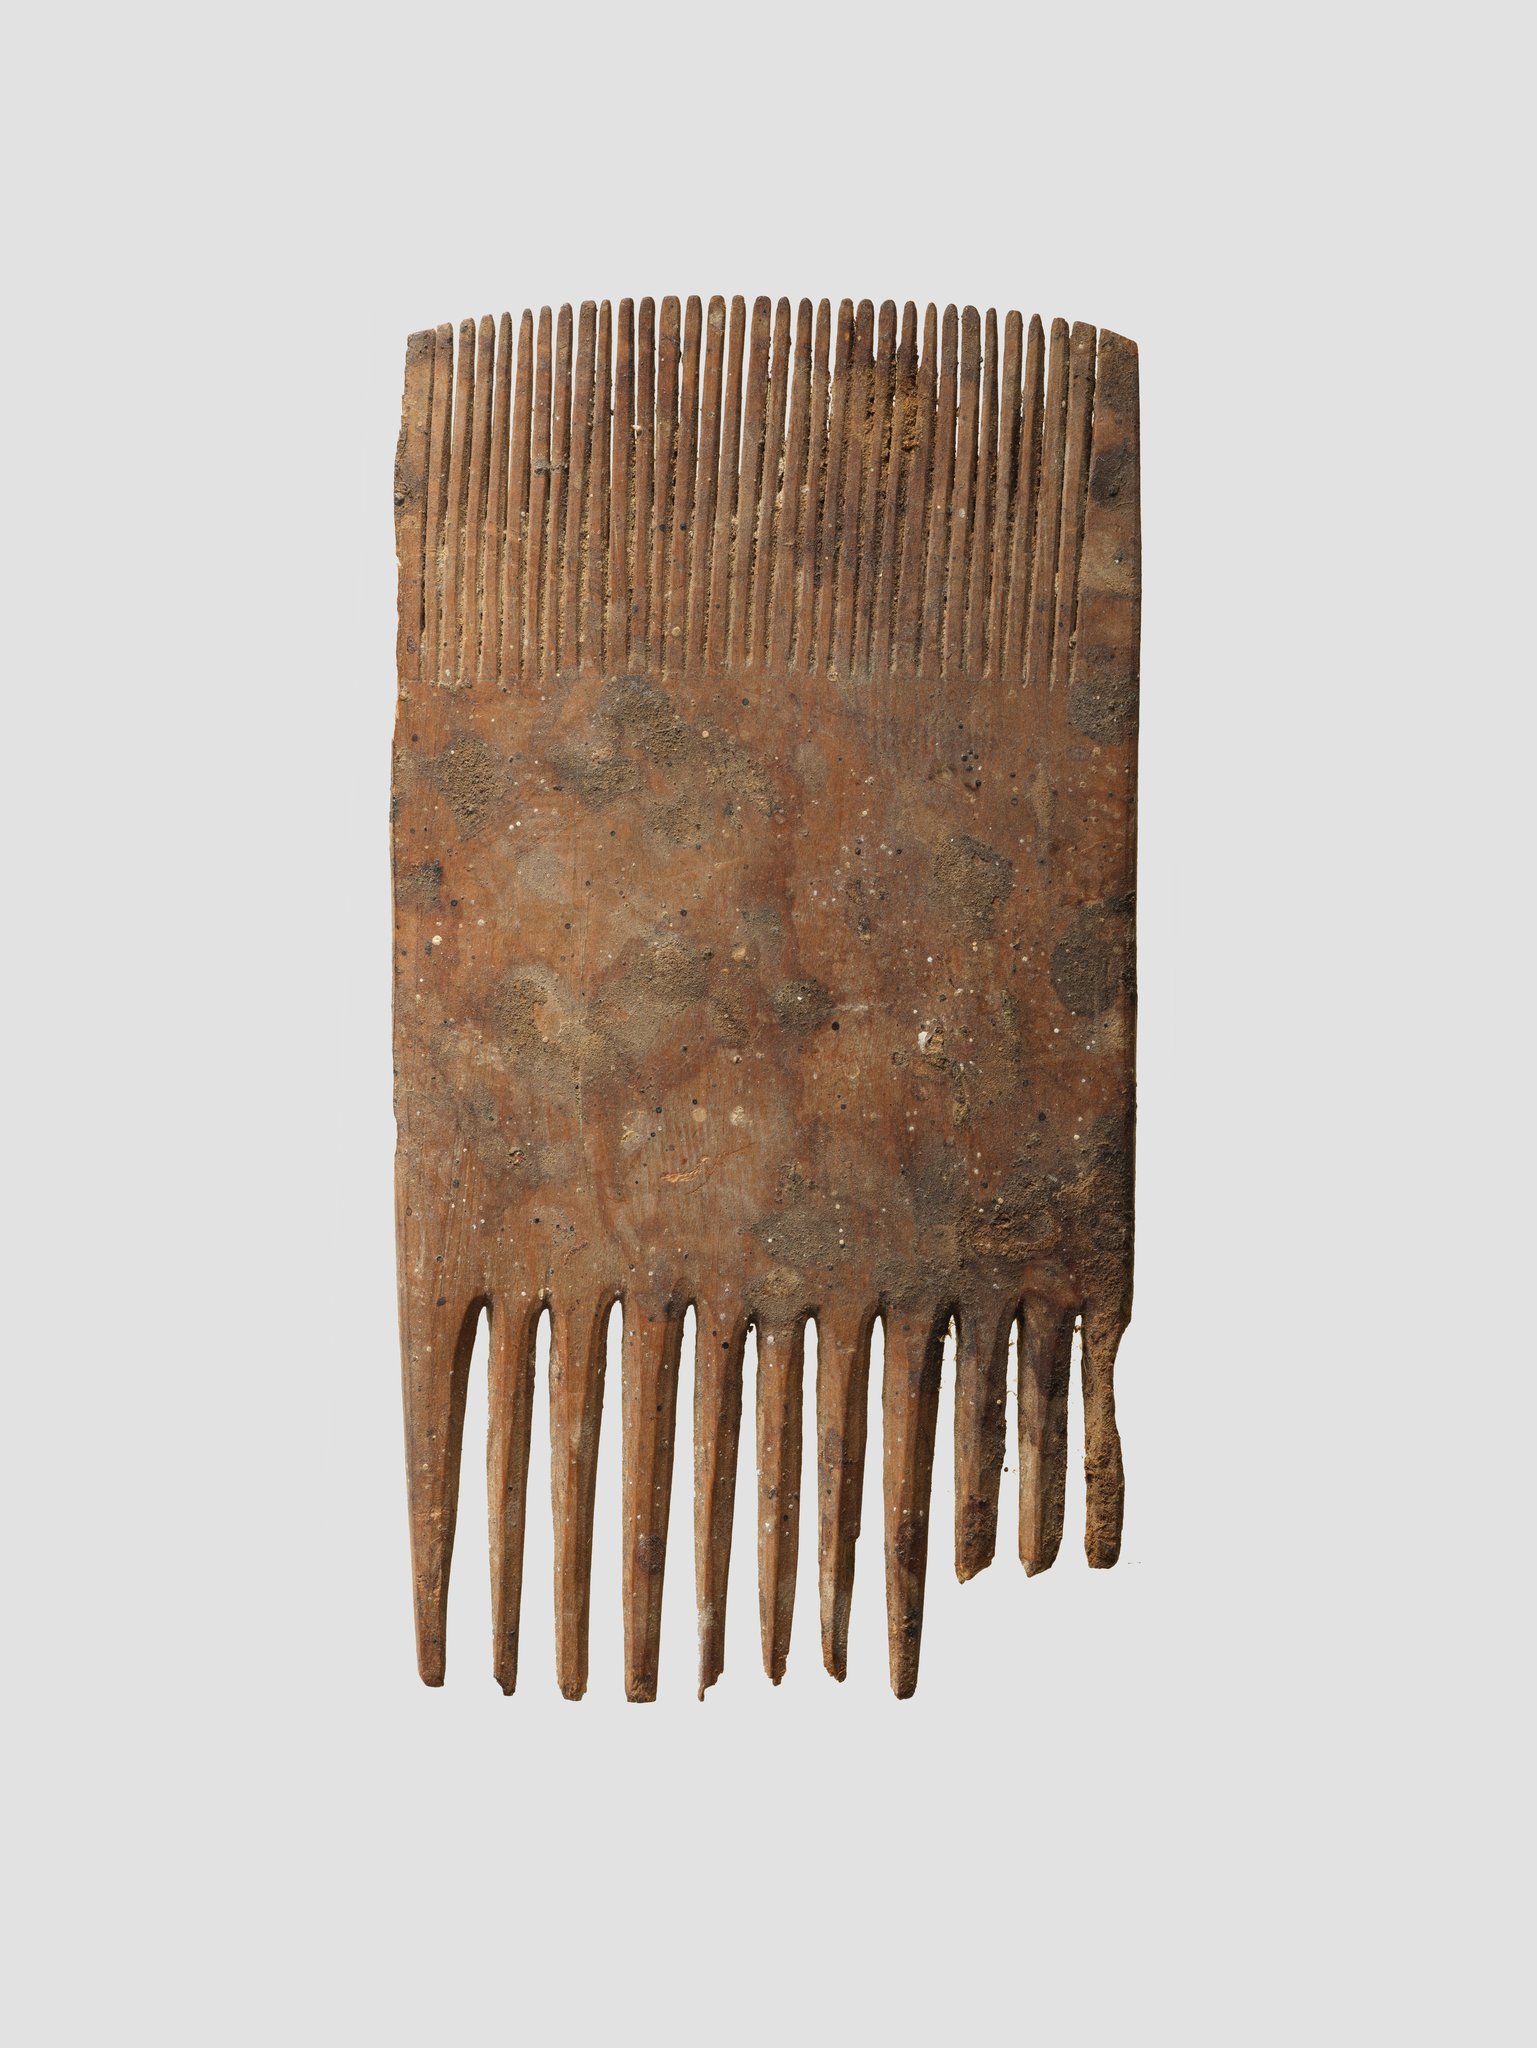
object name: comb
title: Double-sided wooden comb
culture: alanic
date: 601-900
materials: wood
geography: caucasus